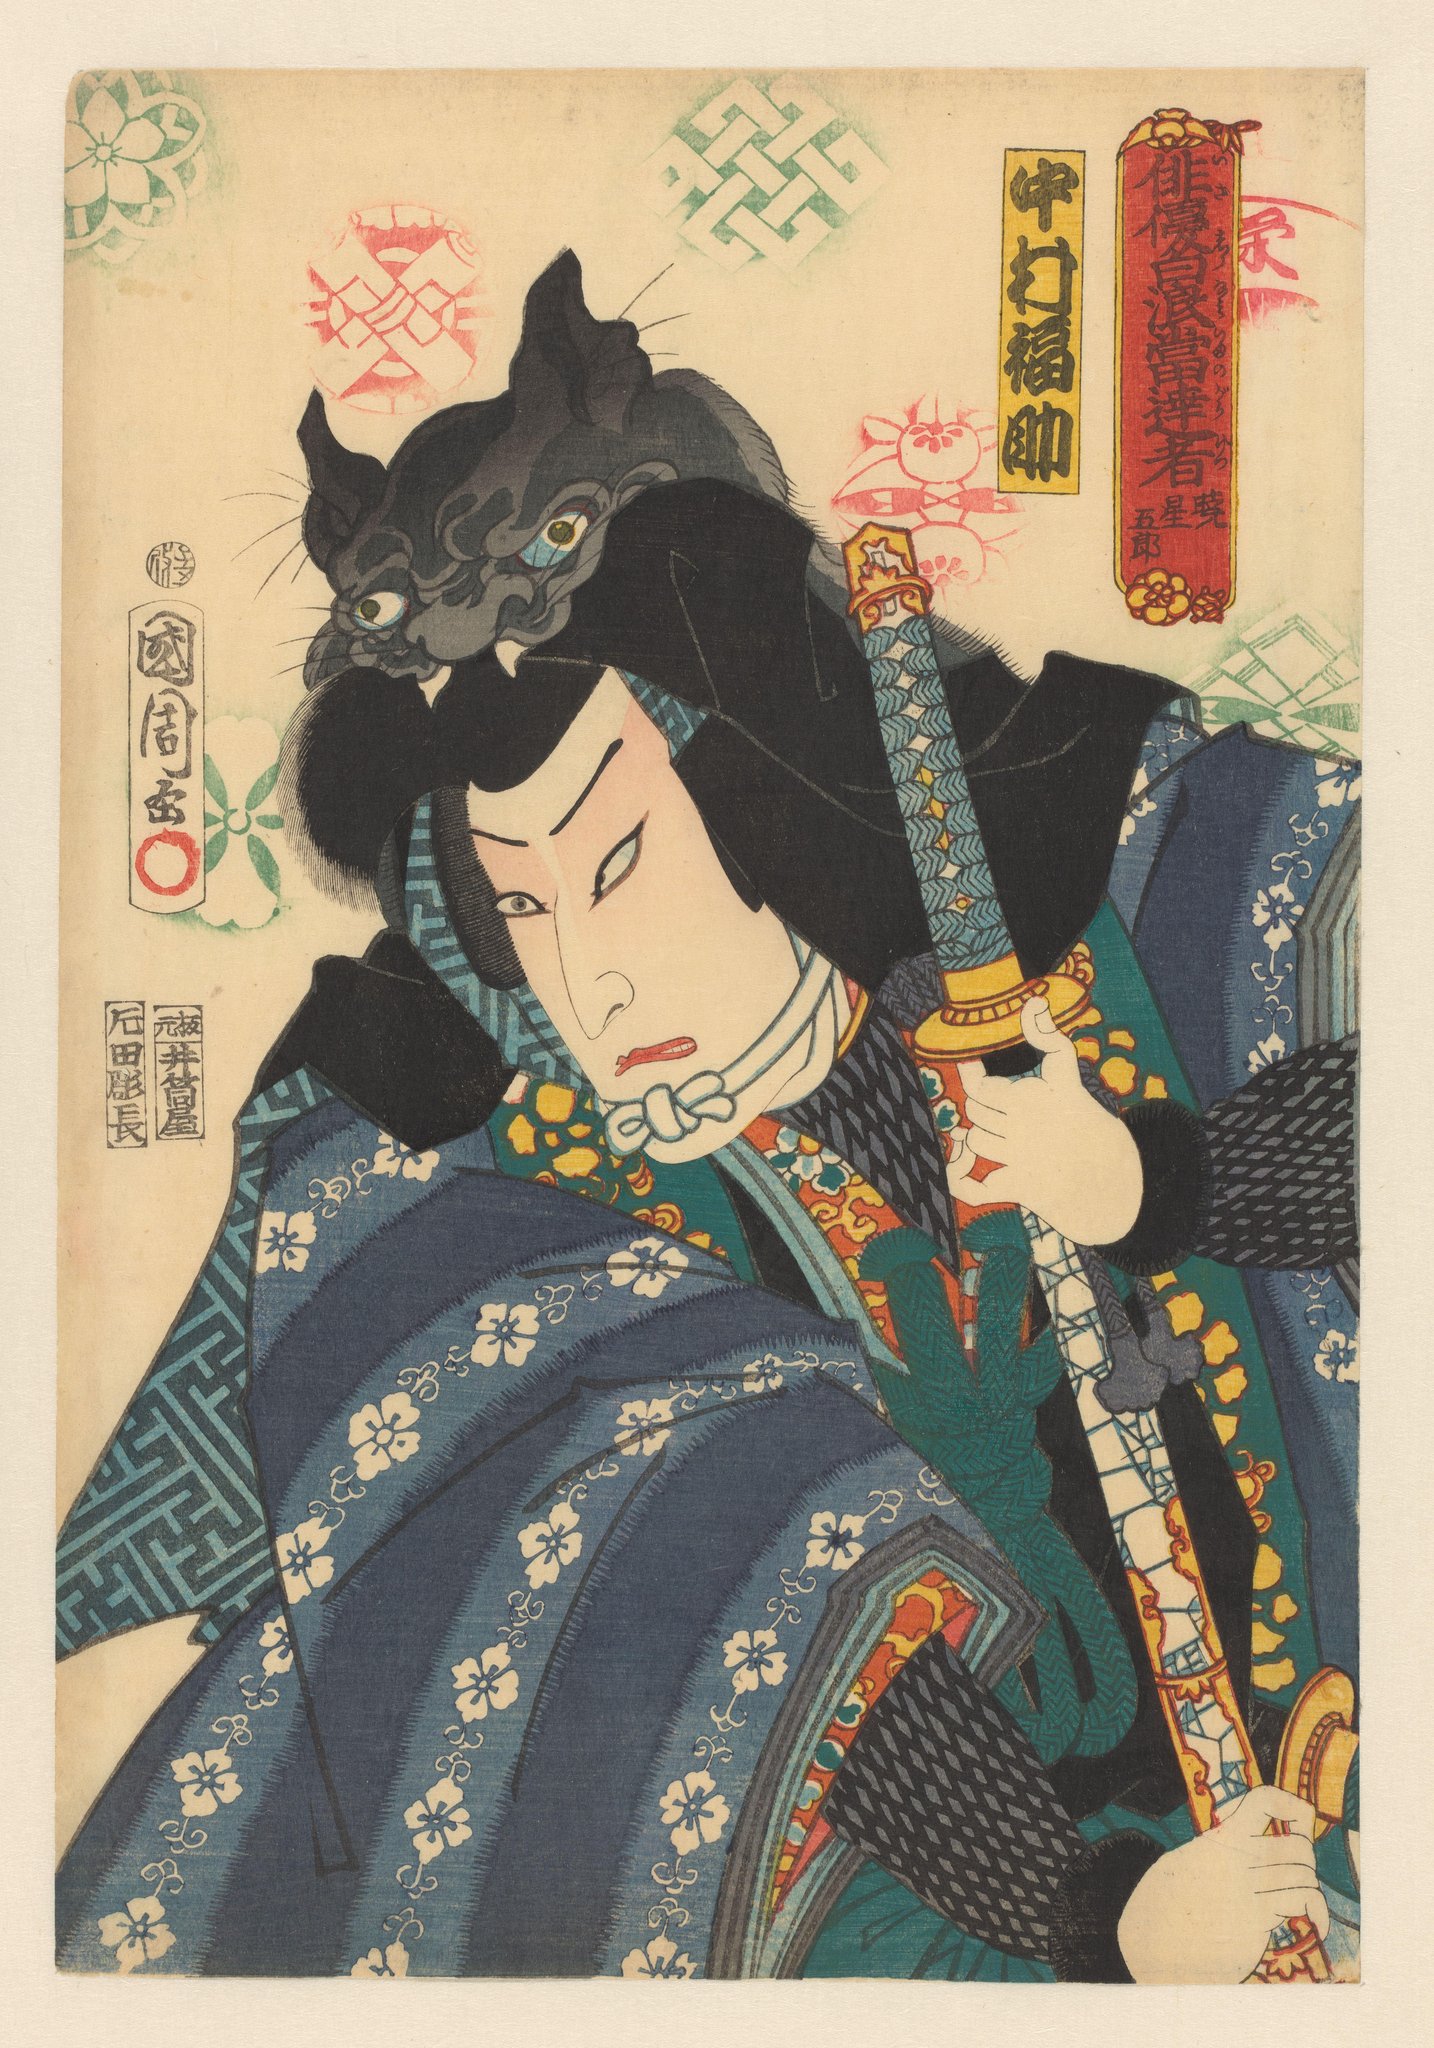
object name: print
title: Akatsuki Hoshigorô with bat cap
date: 1805-1864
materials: paper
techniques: woodcut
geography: japan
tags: head-gear, hacking and thrusting weapons: sword, portrait of actor, actress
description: De bandiet Akatsuki Hoshigorô (hier vertolkt door kabuki acteur Nakamura Fukusuke I) met beide handen om zwaard en vleermuis kap op zijn hoofd.